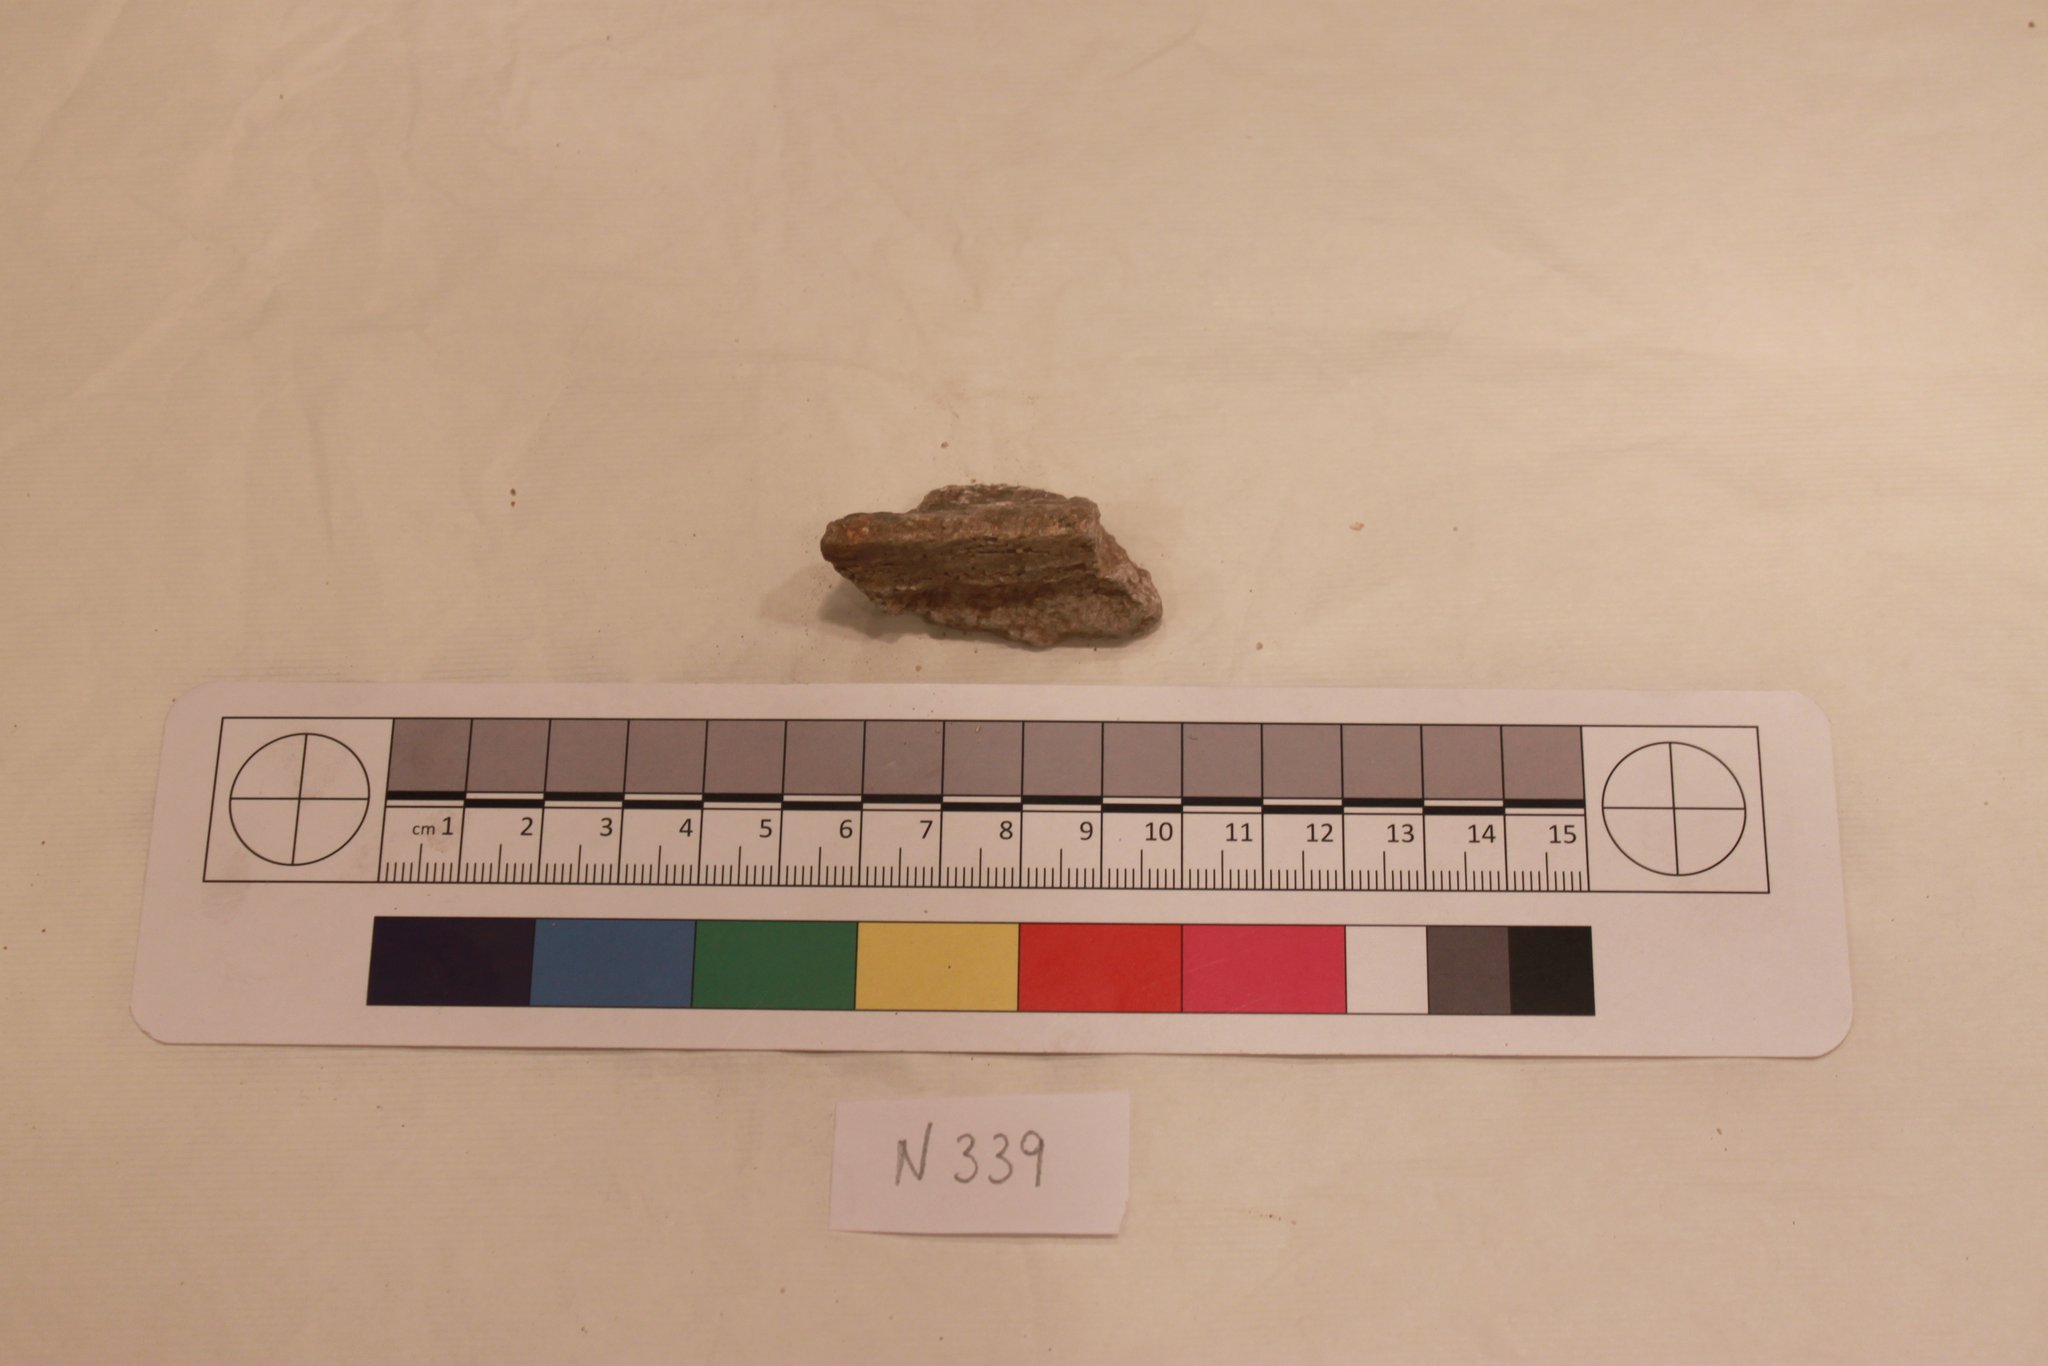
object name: fragment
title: Stucco Fragment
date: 701-1200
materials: plaster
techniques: carving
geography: iran